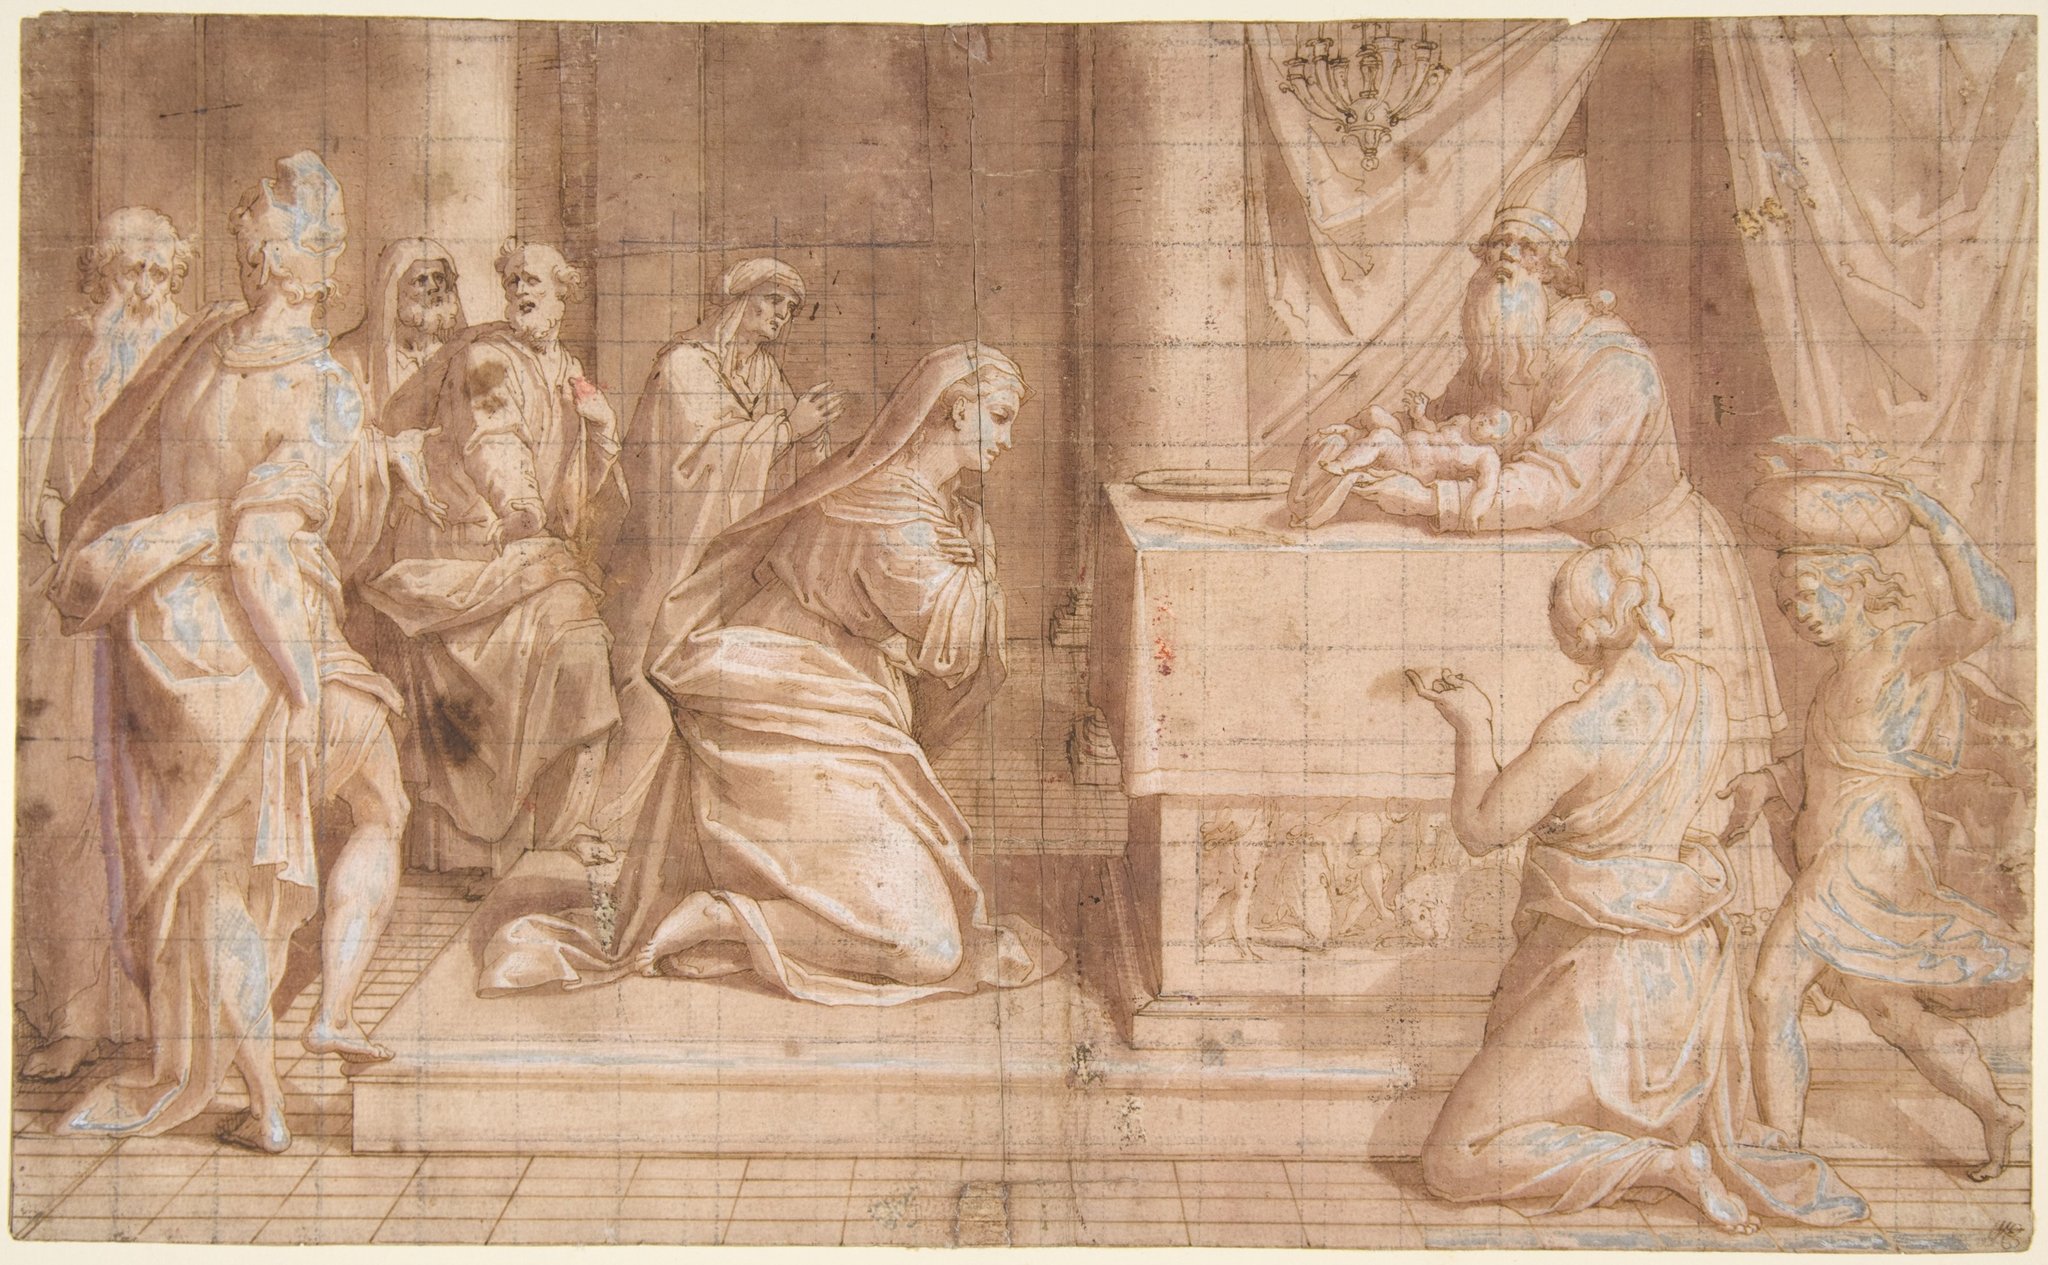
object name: drawing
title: The Circumcision of Jesus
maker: giovanni battista trotti ("il malosso")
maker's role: artist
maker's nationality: italian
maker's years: 1556-1619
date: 1555-1619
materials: chalk, ink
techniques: brush, highlighting, pen, drawing, wash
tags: men,women,virgin mary,jesus,circumcision